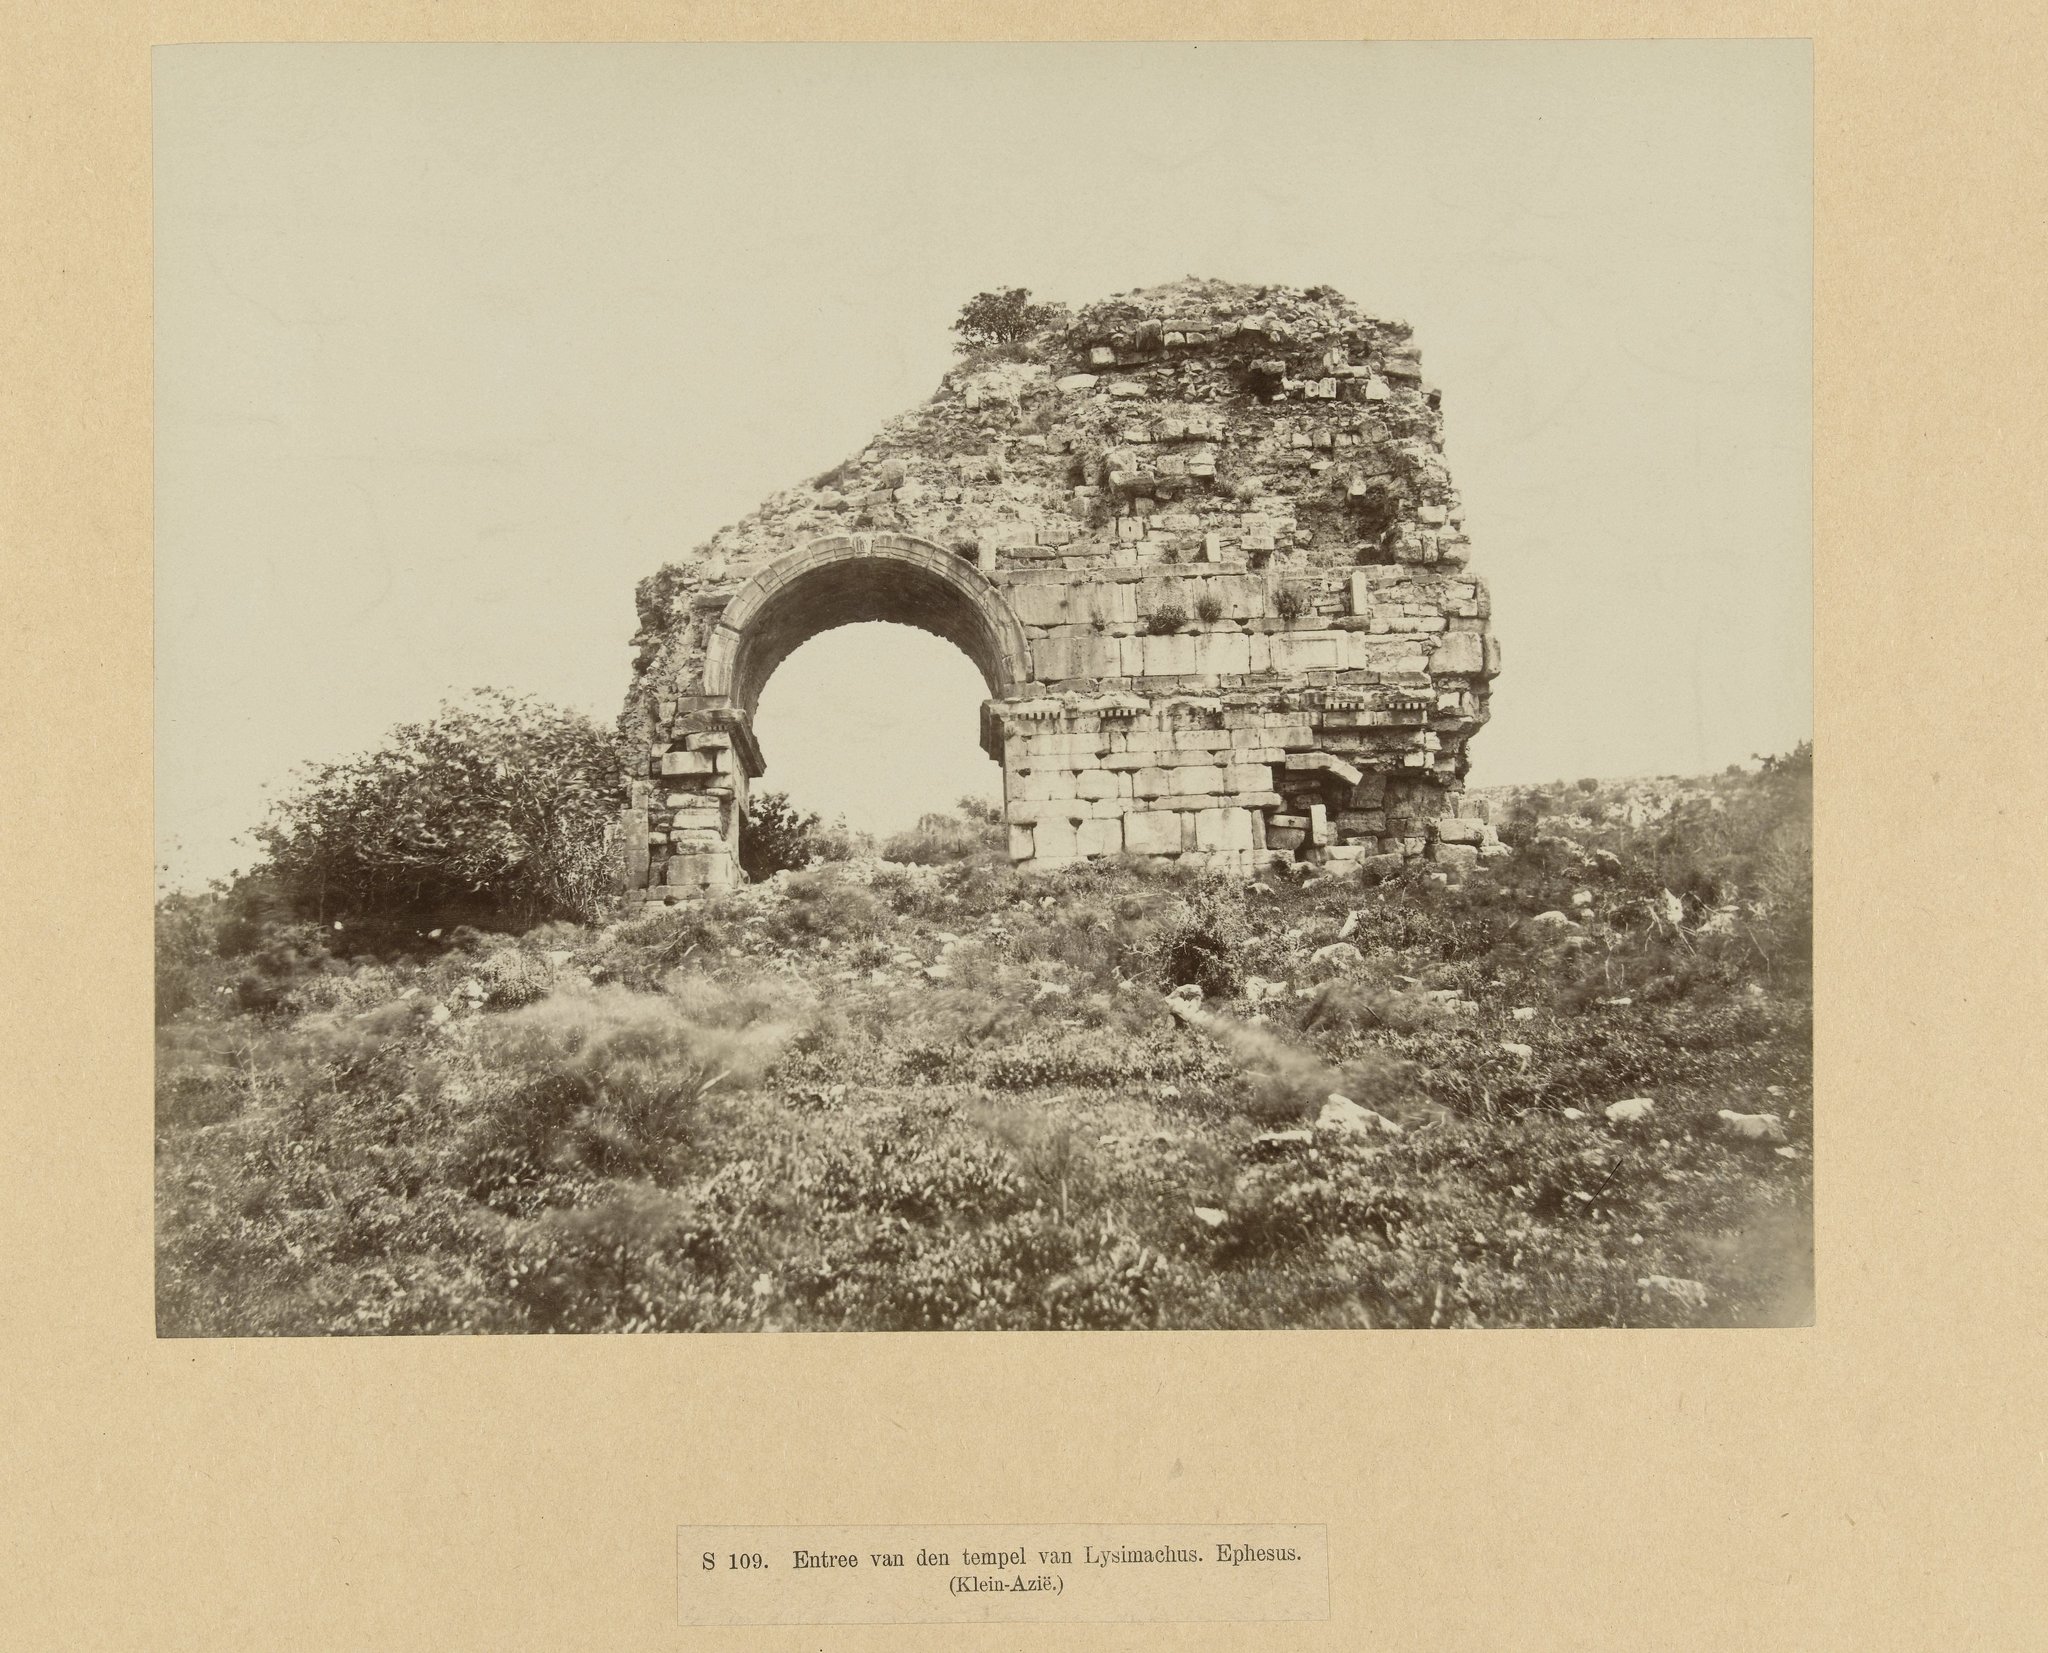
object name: photograph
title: S 109. Entree van den tempel van Lysimachus. Ephesus. (Klein-Azië)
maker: Anonymous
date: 1890-1895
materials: cardboard, paper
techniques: albumen print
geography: efeze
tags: ruin of a building ~ architecture, arch, archivolt ~ architecture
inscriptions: stamp: ‘Gemeentelijke bibliotheek/ Rotterdam’, check stamp: ‘Bristol/ L.M.’, title: ‘S 109. Entree van den tempel van Lysimachus. Ephesus./ (Klein-Azië.)’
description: Onderdeel van een groep door fotograaf Richard Polak op reis verzamelde foto’s. Deze foto is samen met andere op zijn reizen verzamelde foto's tentoongesteld bij de Rotterdamsche Kunstkring (1895), Arti en Amicitiae te Amsterdam (1897-1898?) en Societeit 't Collegie te Kampen (datum vooralsnog onbekend).